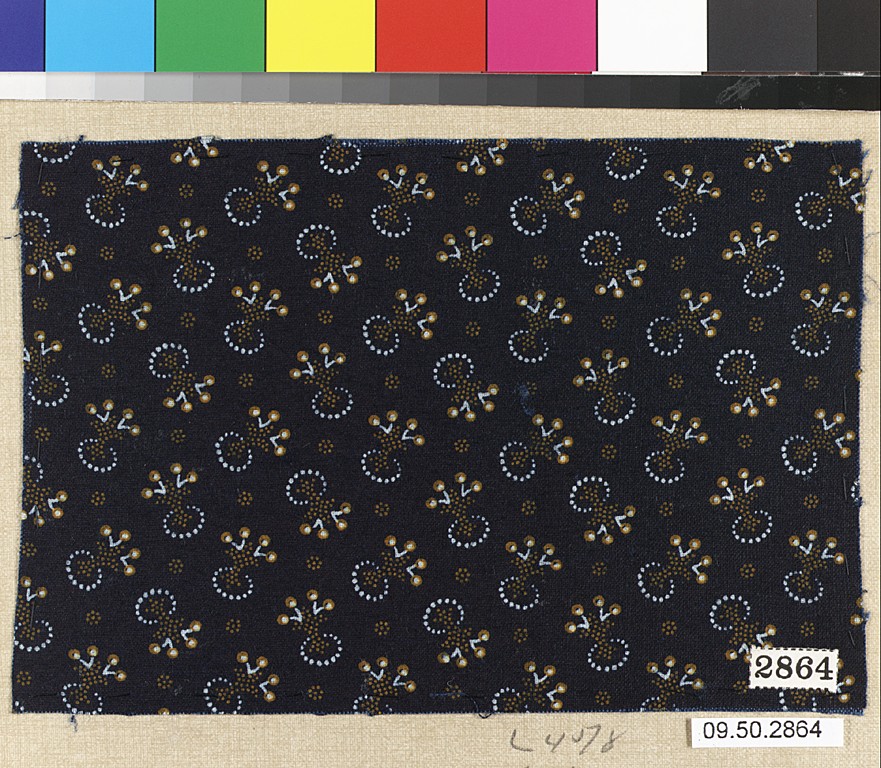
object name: piece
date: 1801-1900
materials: cotton